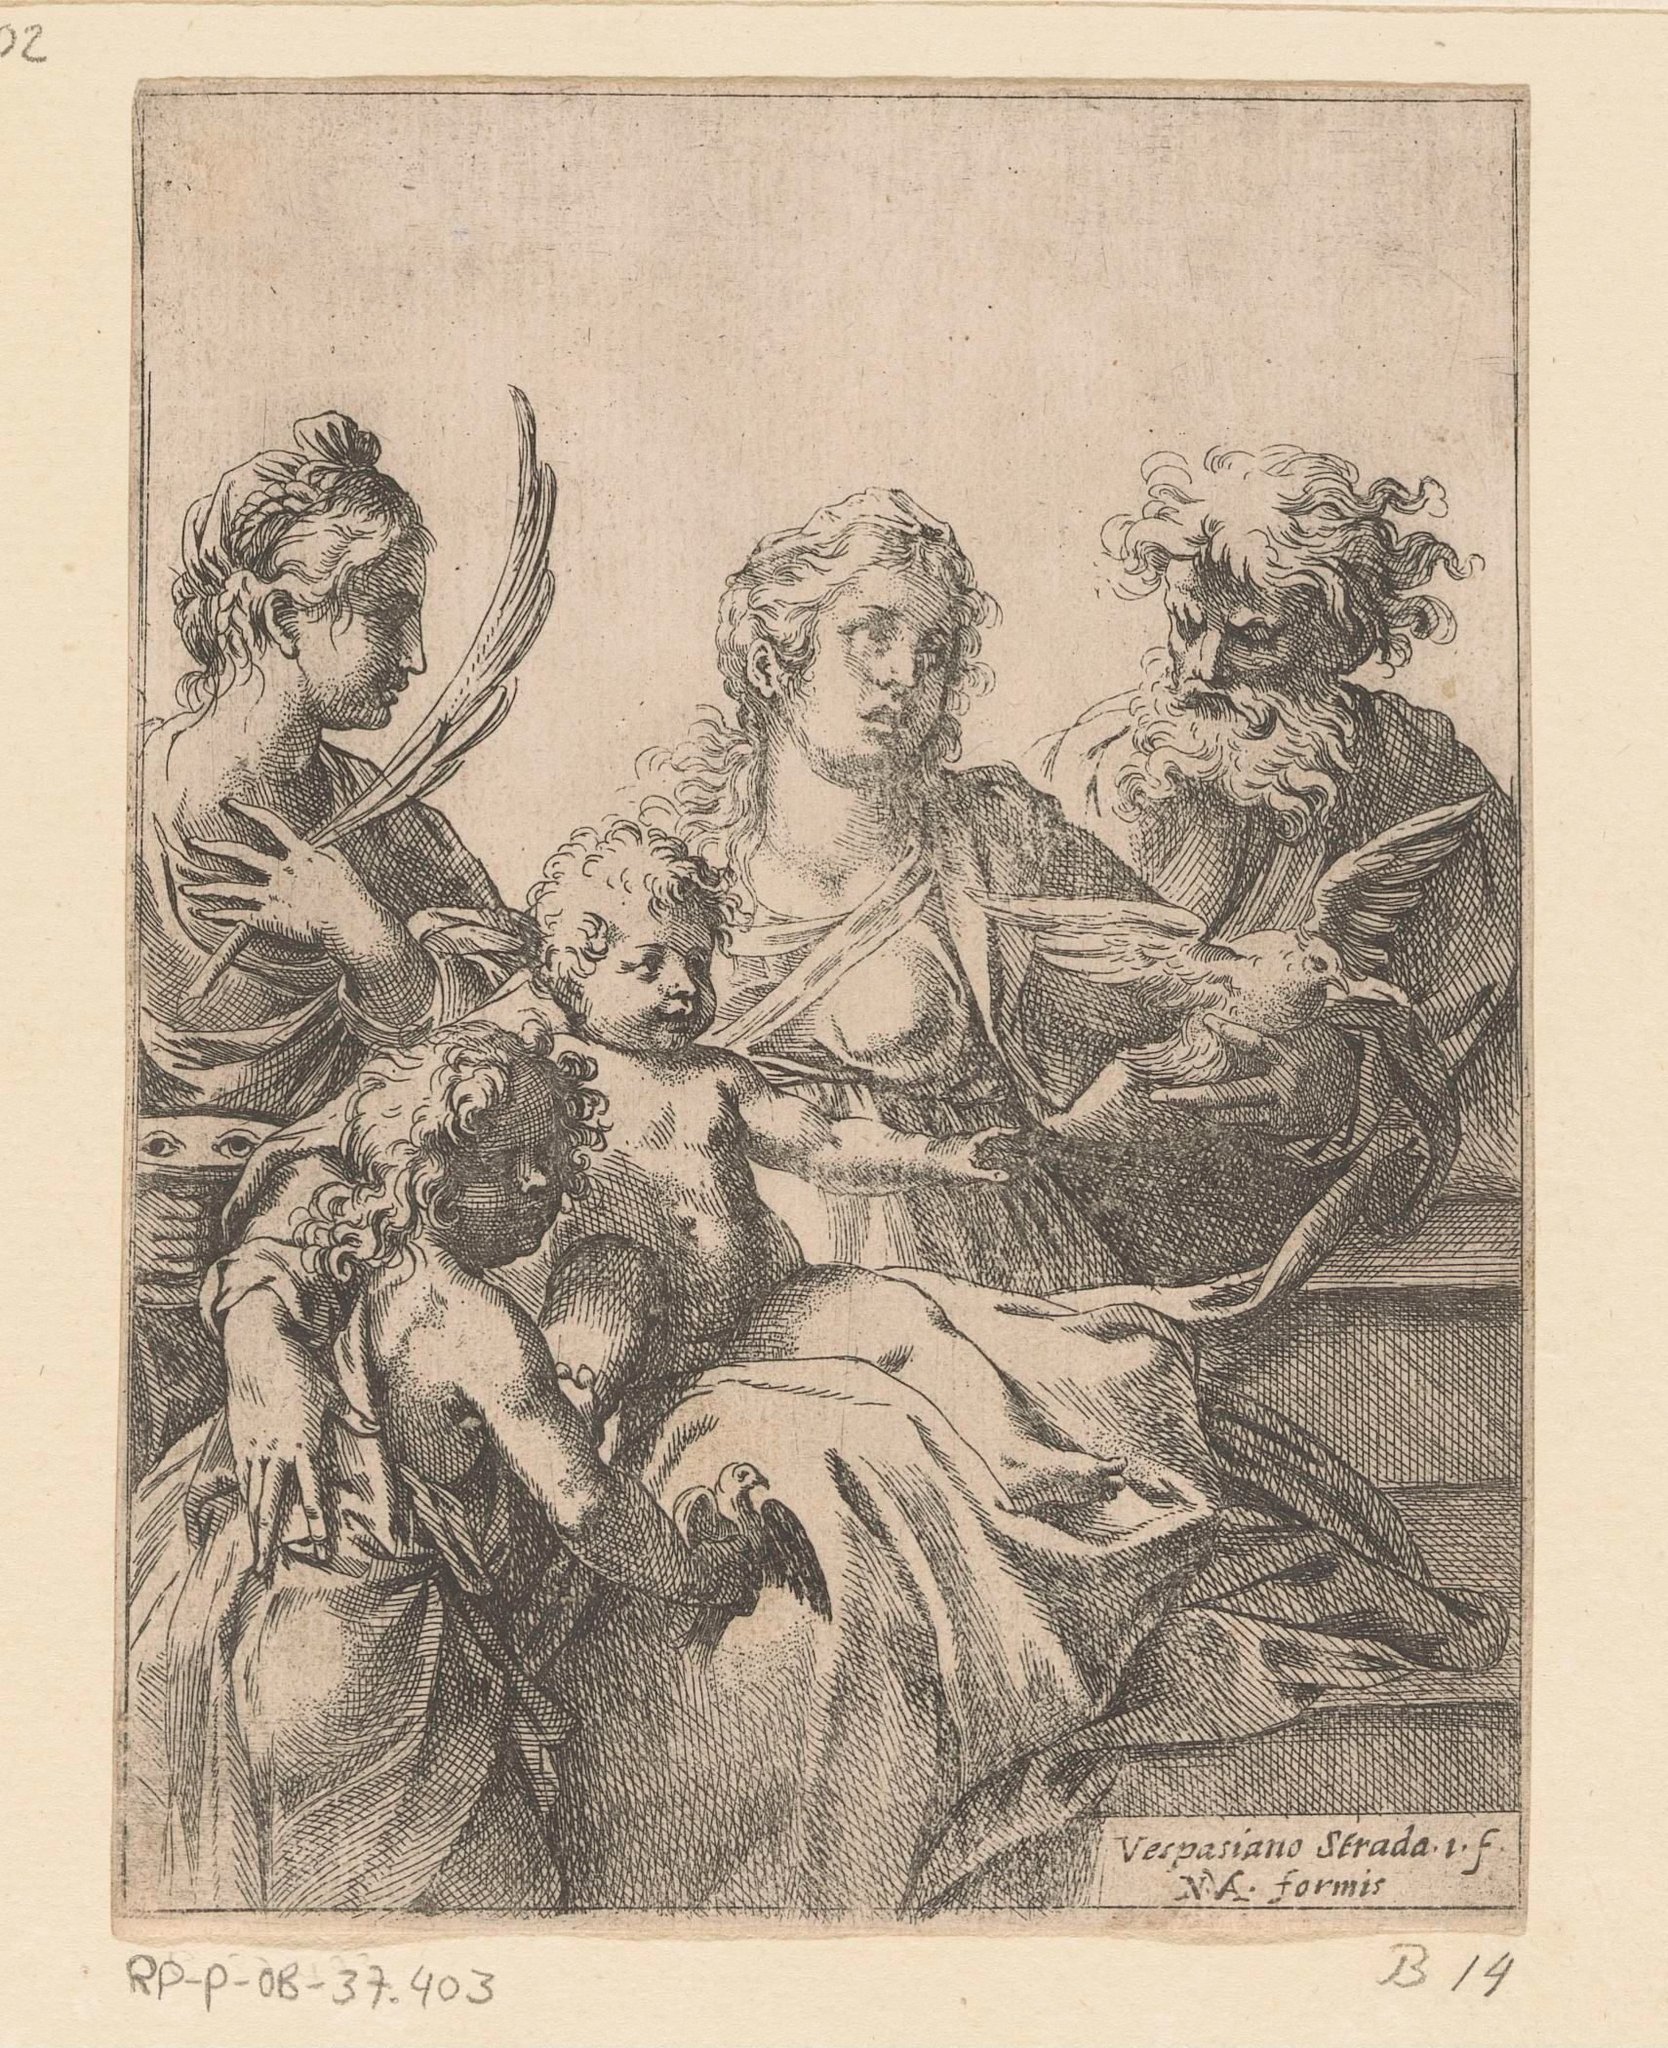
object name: print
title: Heilige Familie met Johannes de Doper en Hl. Lucia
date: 1592-1613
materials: paper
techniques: etching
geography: italy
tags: the virgin martyr lucy (lucia) of syracuse; possible attributes: dagger or sword (in neck), eyes, flames at feet, lamp, ox, holy family with john the baptist, elisabeth present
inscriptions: collector's mark: Lugt 240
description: In het midden Maria met een duif in haar hand en het Christuskind op schoot. Rechts Jozef en links de jonge Johannes de Doper en de Heilige Lucia met een palmtak en haar ogen op een plateau.